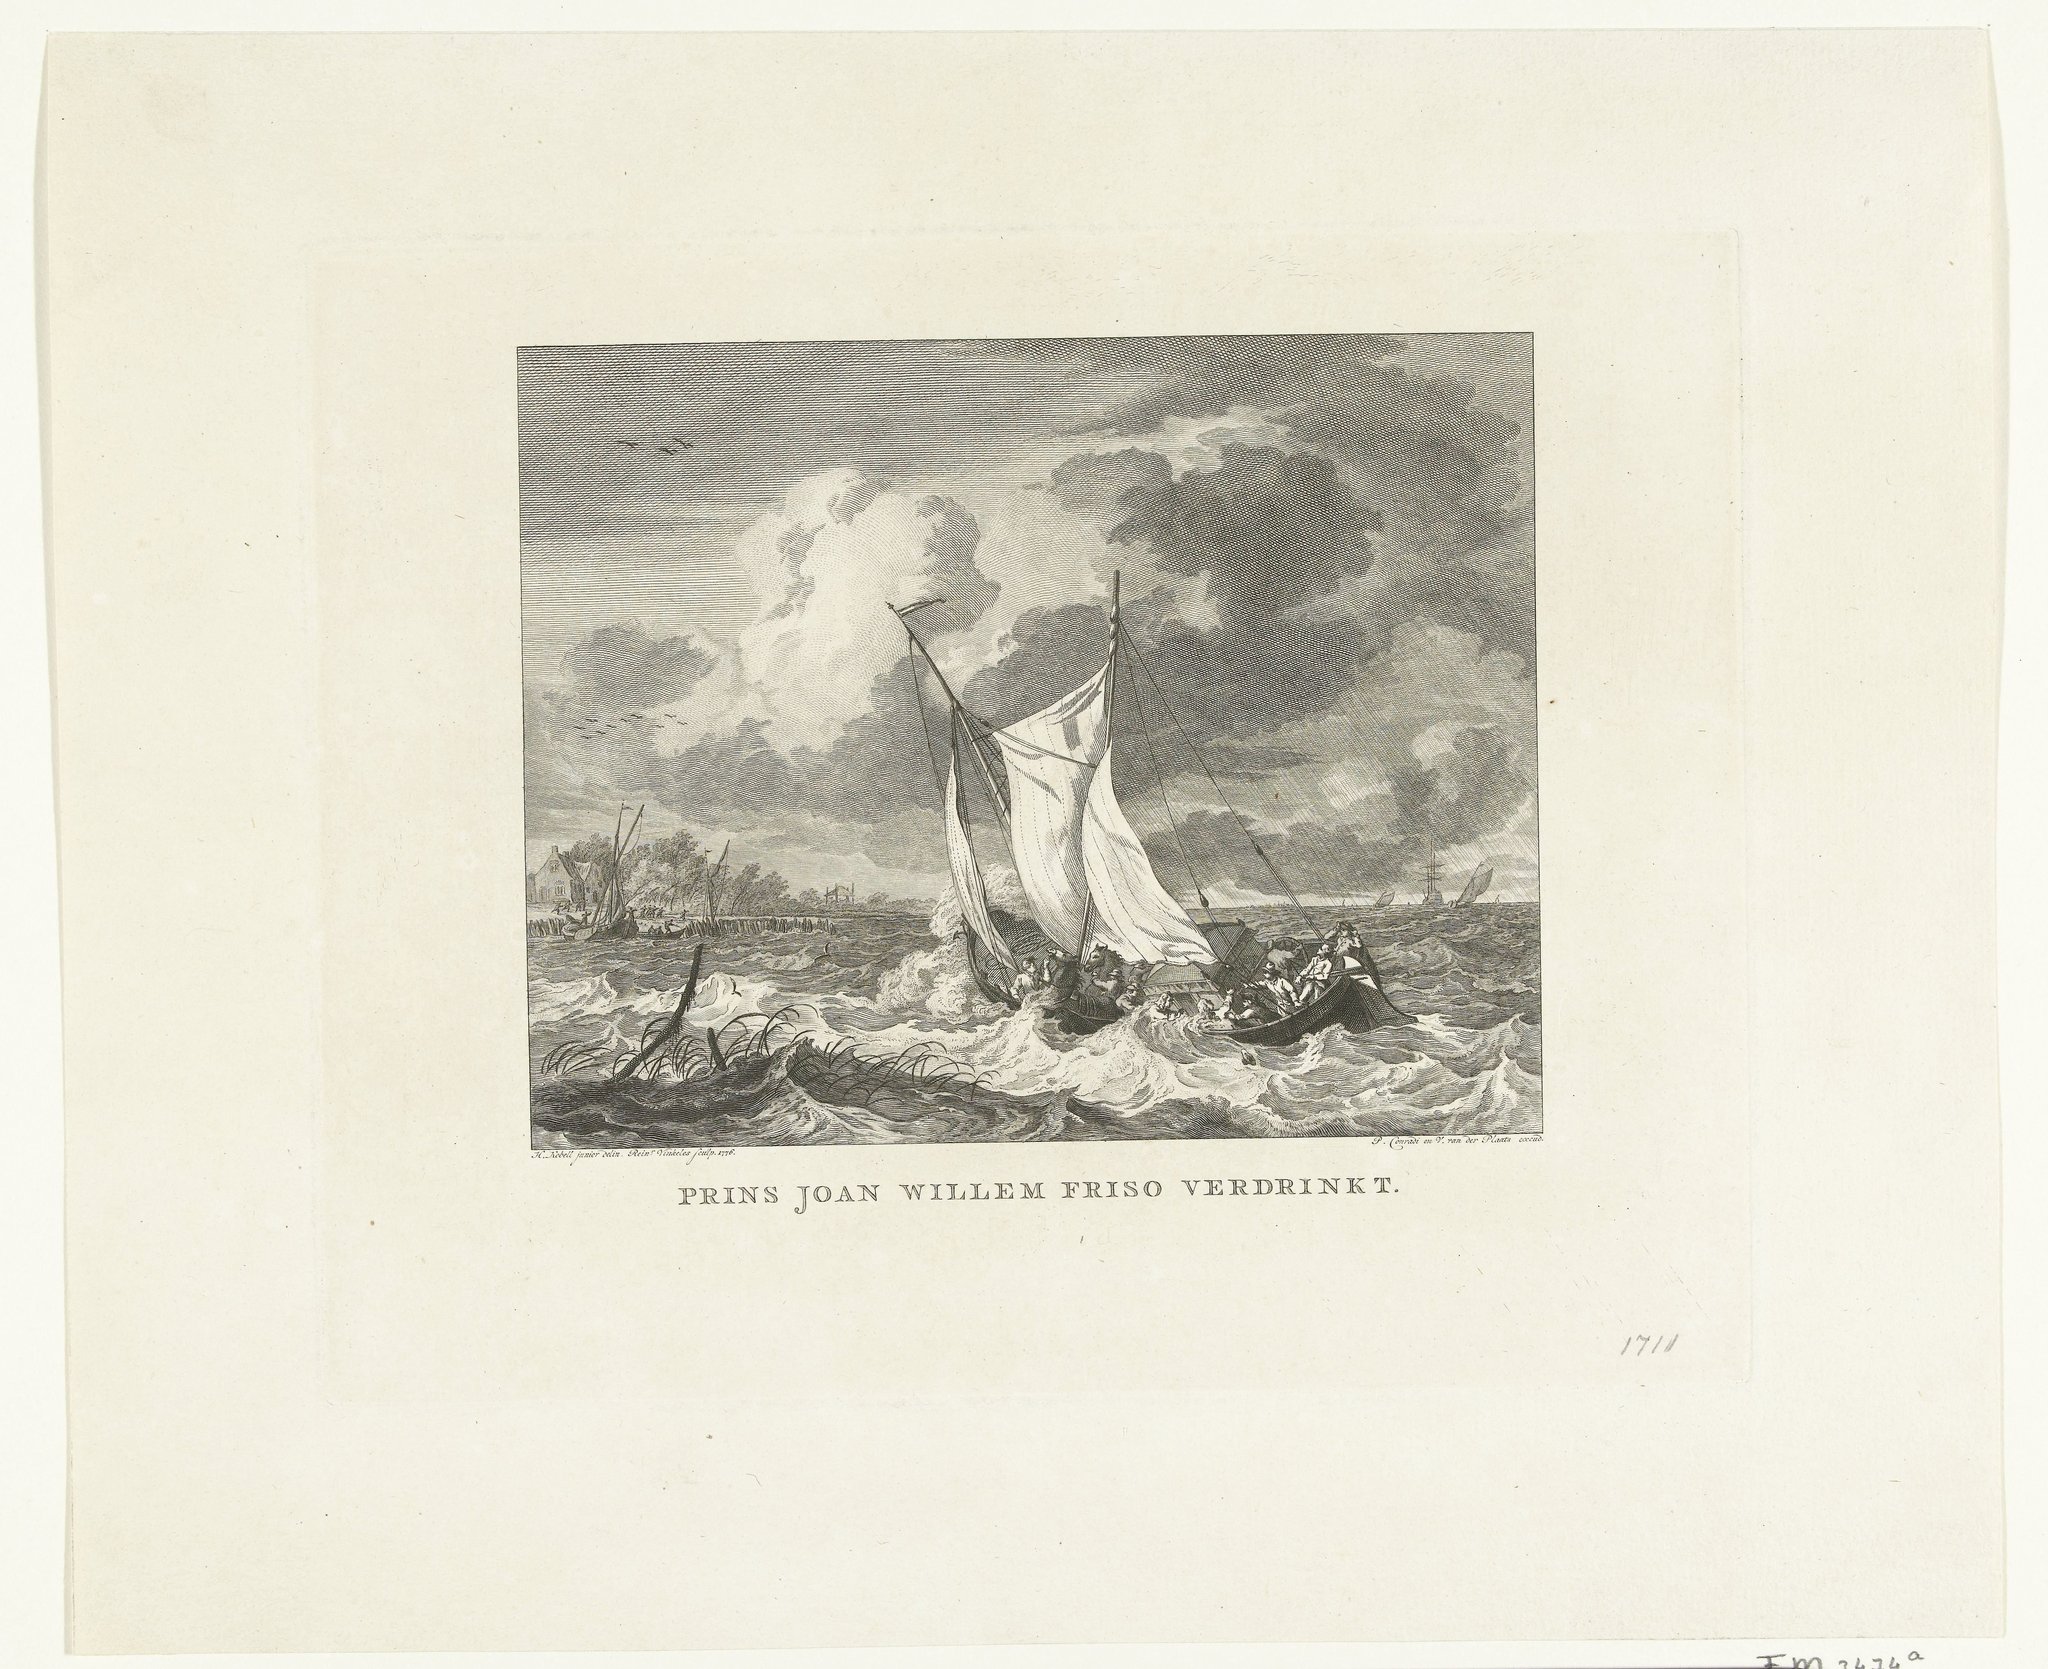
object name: history print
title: Verdrinkingsdood van prins Johan Willem Friso, 1711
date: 1776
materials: paper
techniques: etching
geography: northern netherlands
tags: johan willem friso (prins van oranje-nassau), death by drowning (non-violent)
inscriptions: date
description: Johan Willem Friso, prins van Oranje-Nassau, verdrinkt tijdens het oversteken van de Moerdijk als de boot tijdens zwaar weer op 14 juli 1711 in problemen raakt.